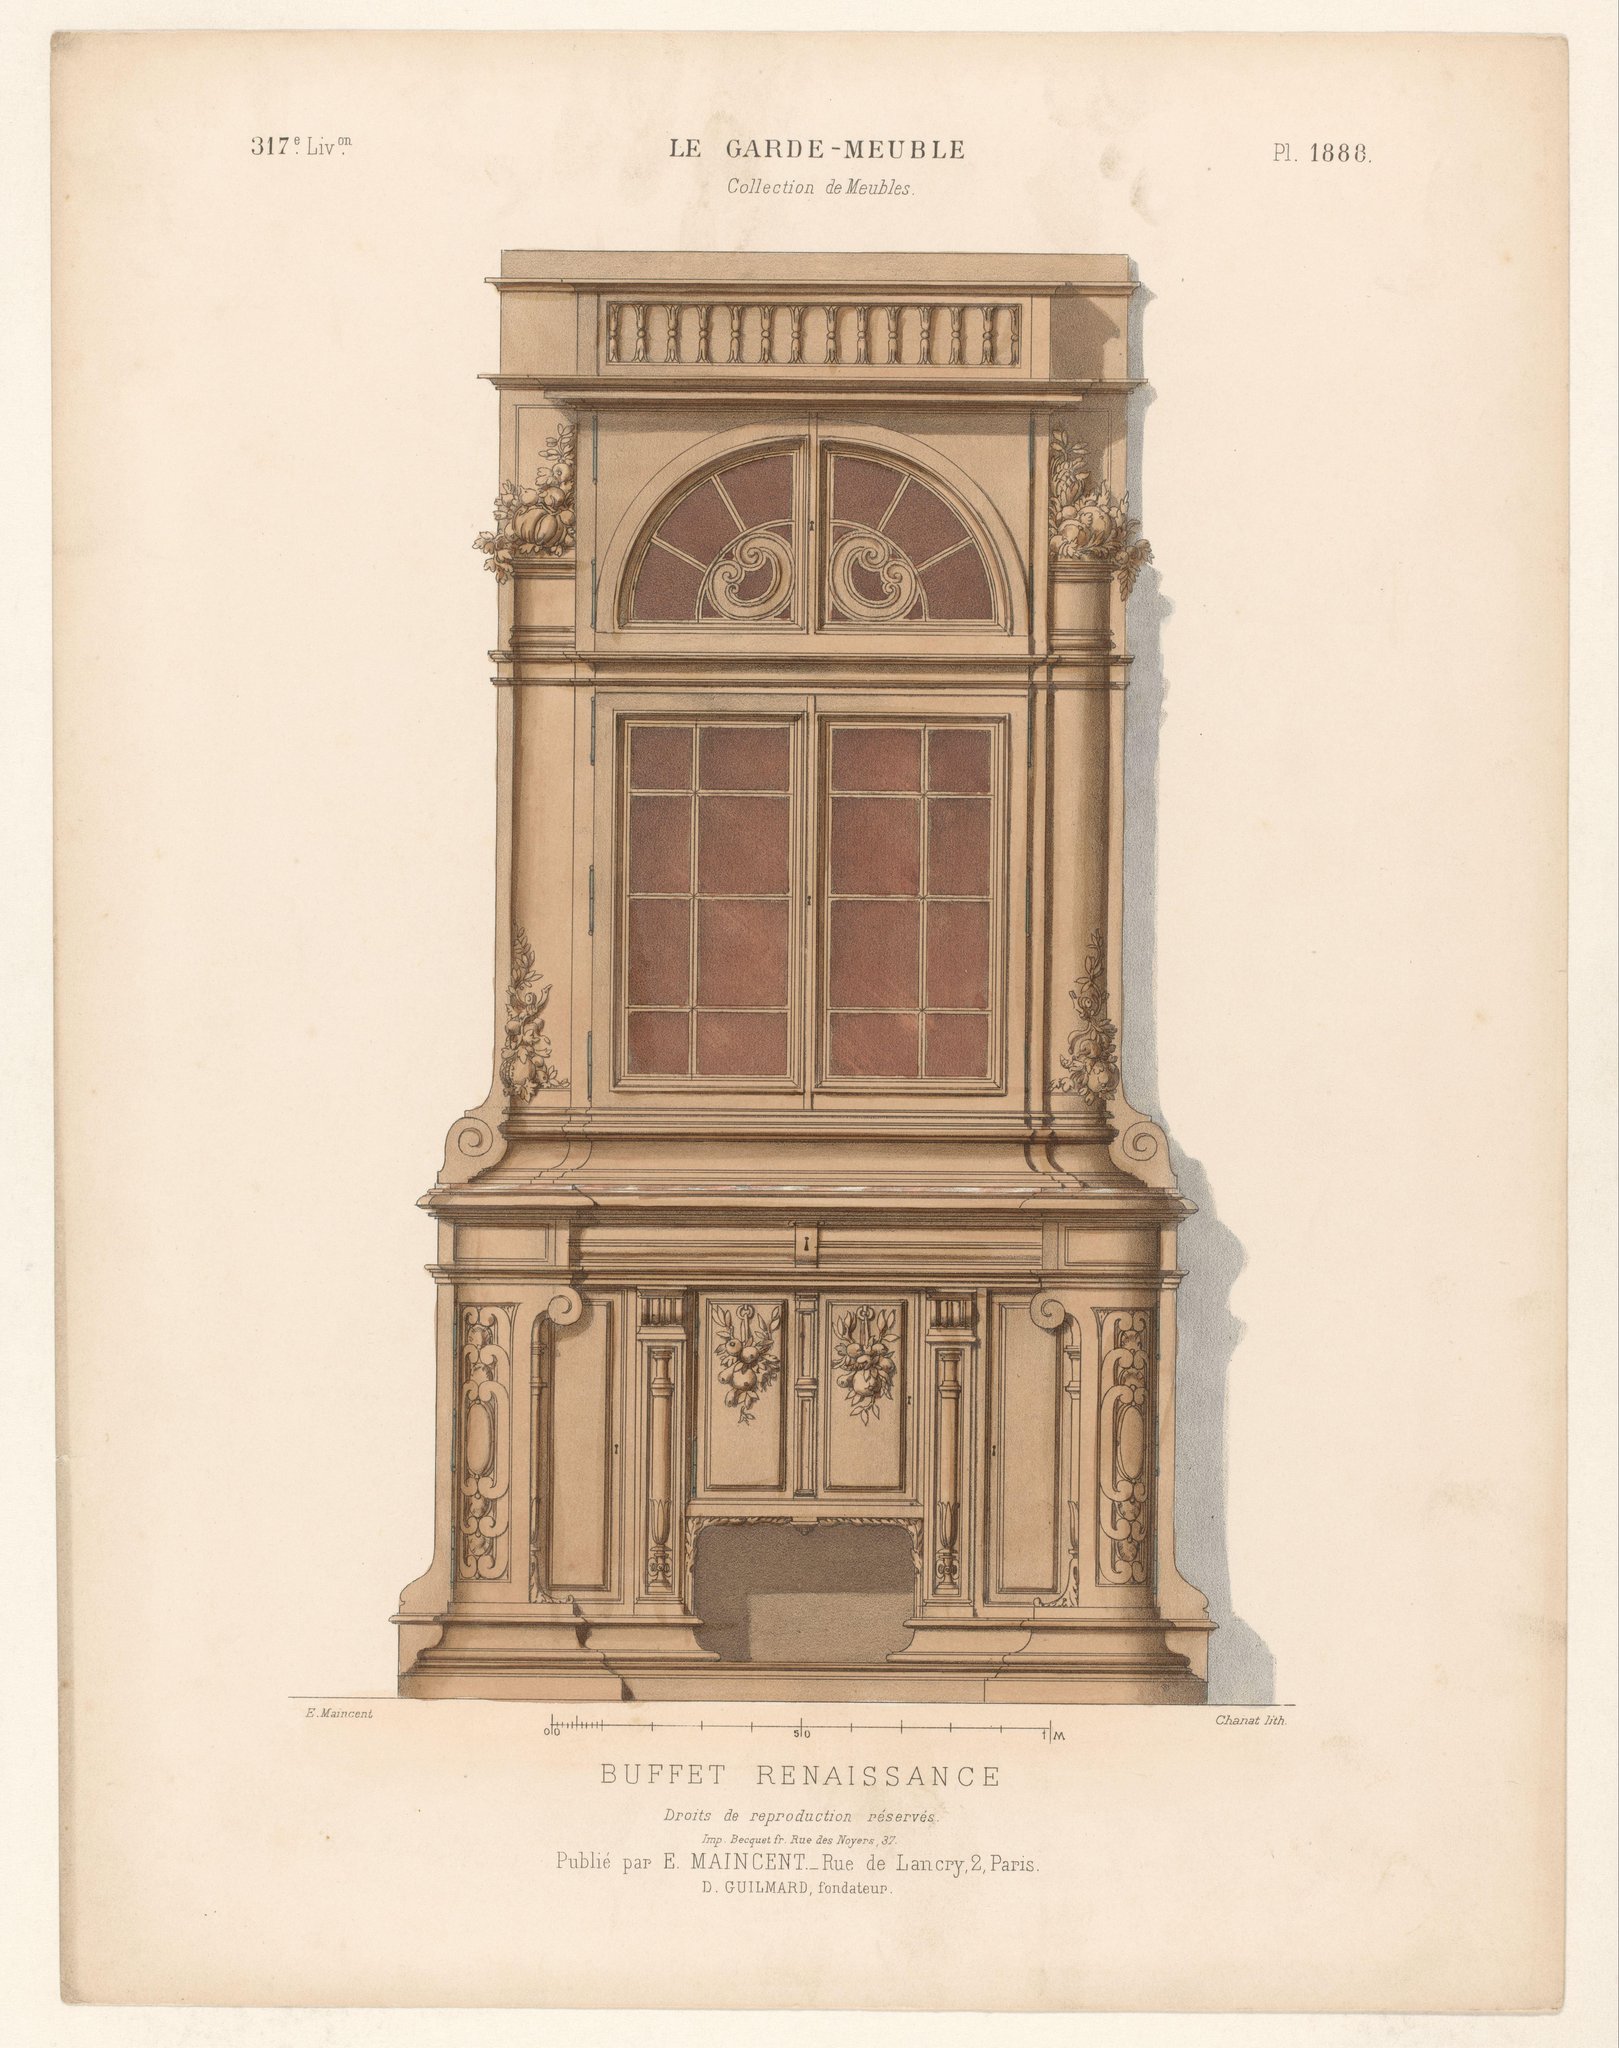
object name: print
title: Buffet renaissance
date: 1885-1895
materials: paper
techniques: hand coloring, lithograph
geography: paris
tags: furniture for storage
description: Ieder Livraison in de serie Le Garde-Meuble bevat negen platen: drie 'sièges' (zitmeubels), drie 'meubles' (diverse meubels zoals tafels en kasten) en drie 'tentures' (gordijnen en draperieën).